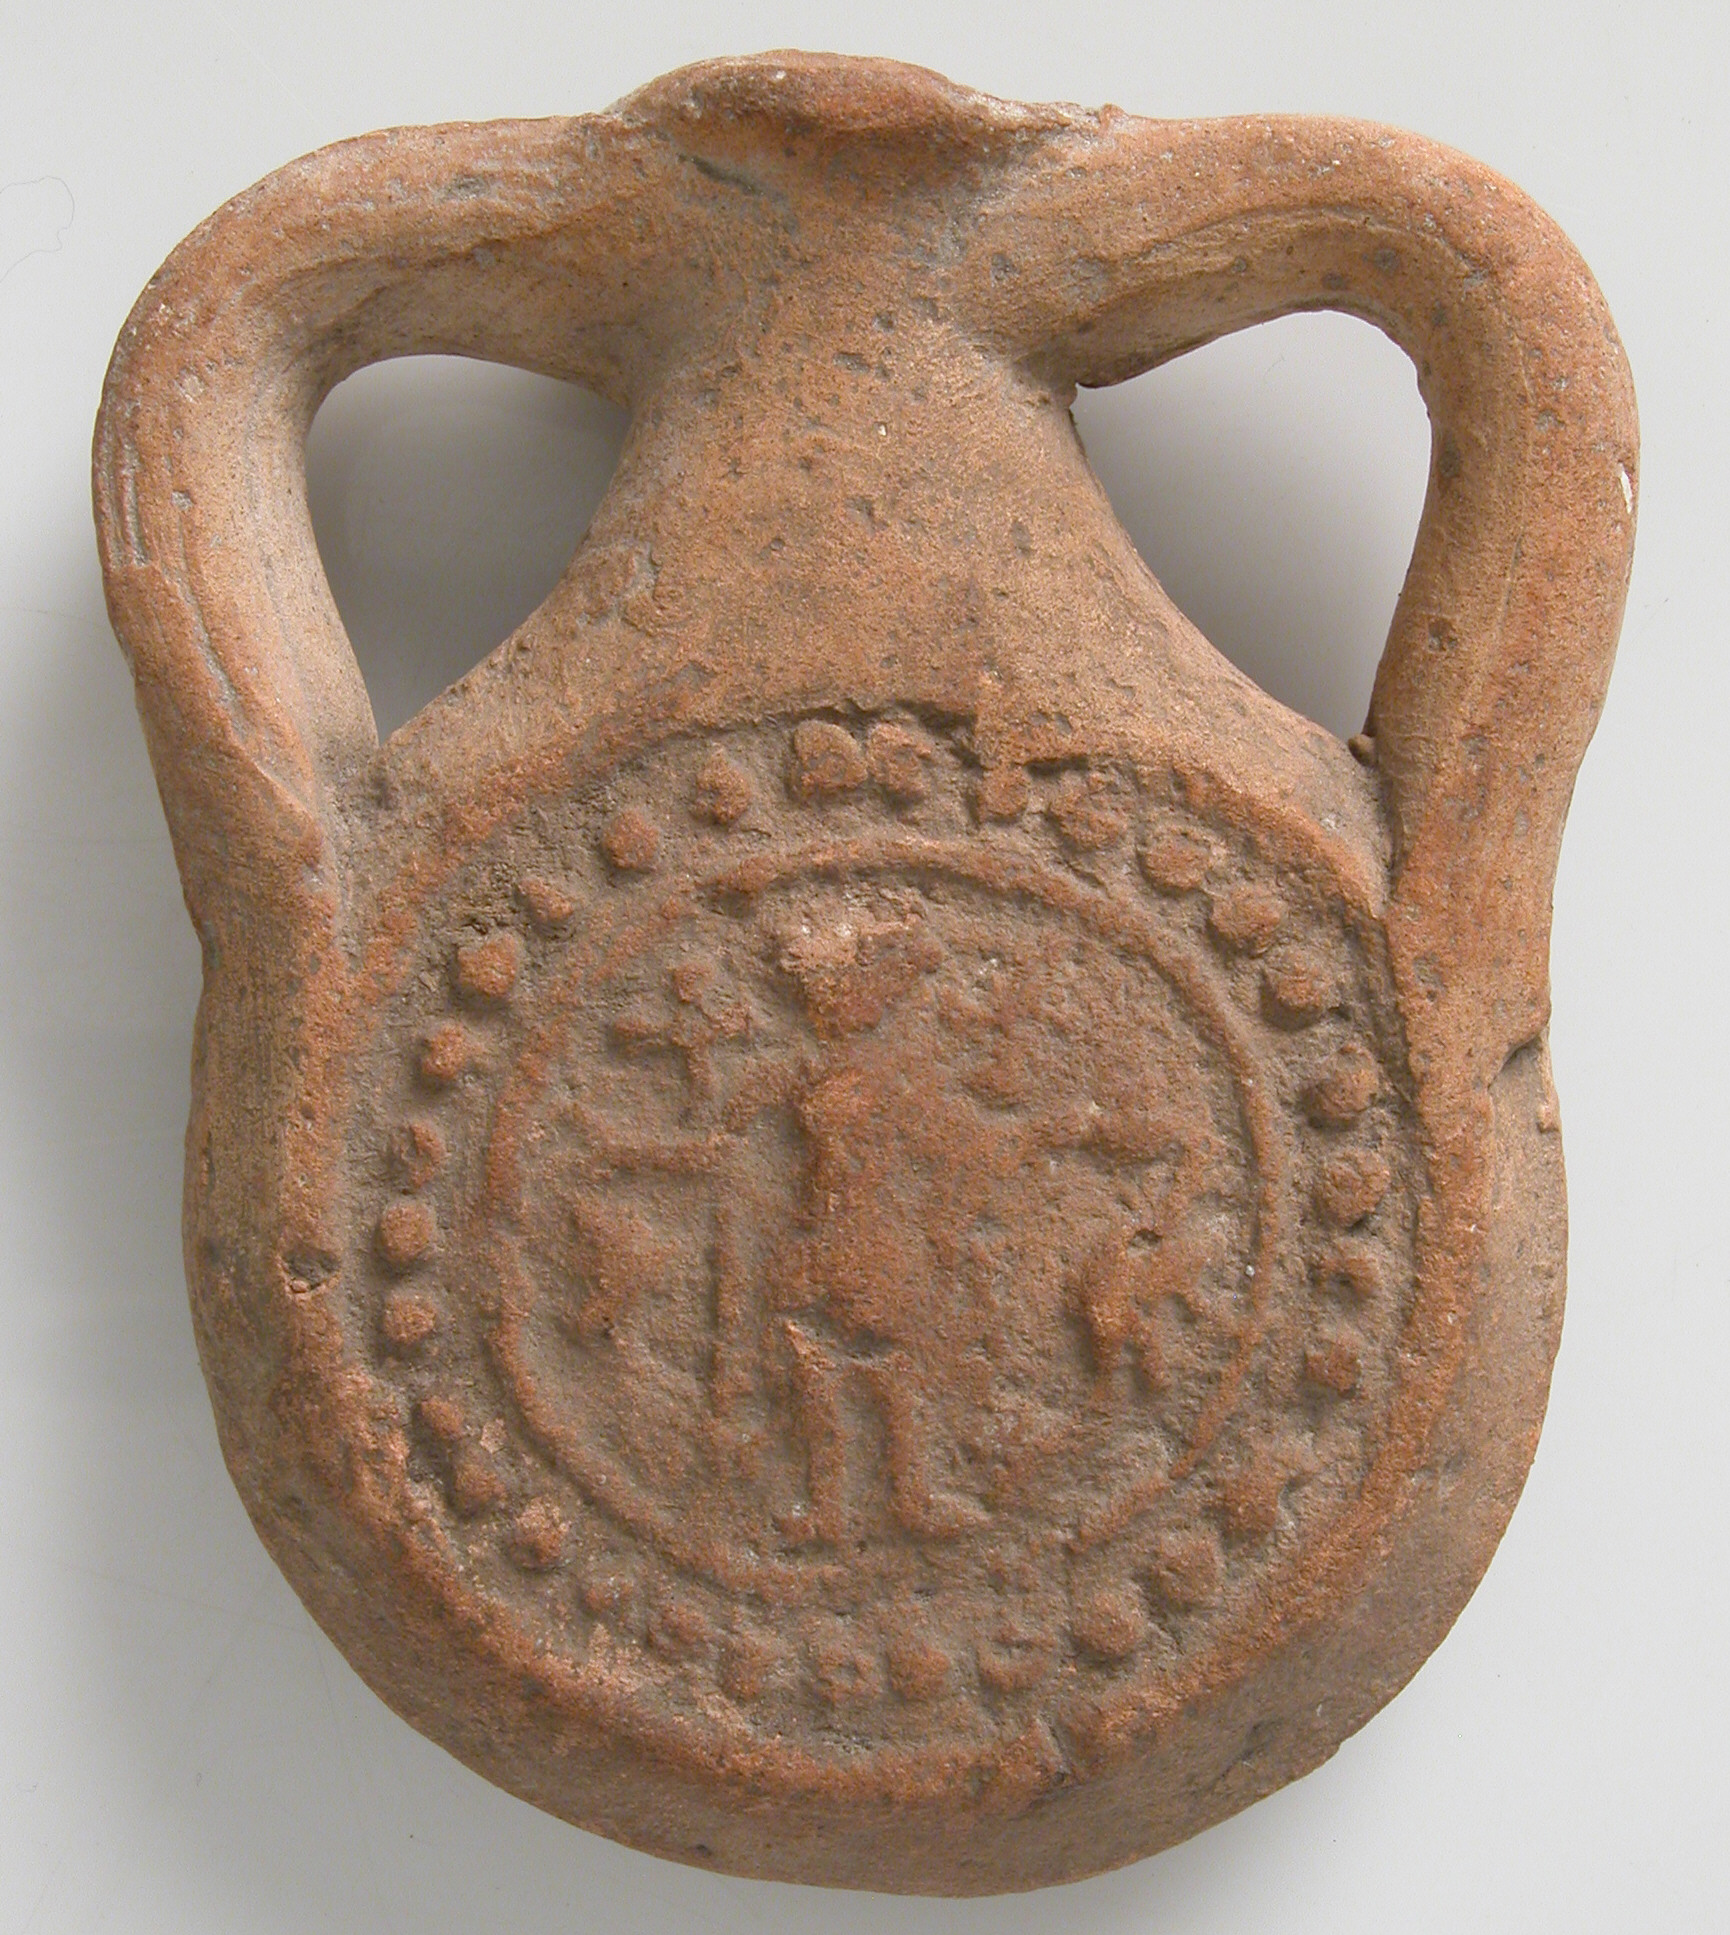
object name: ampulla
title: Pilgrim Flask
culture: coptic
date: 301-700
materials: earthenware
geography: egypt